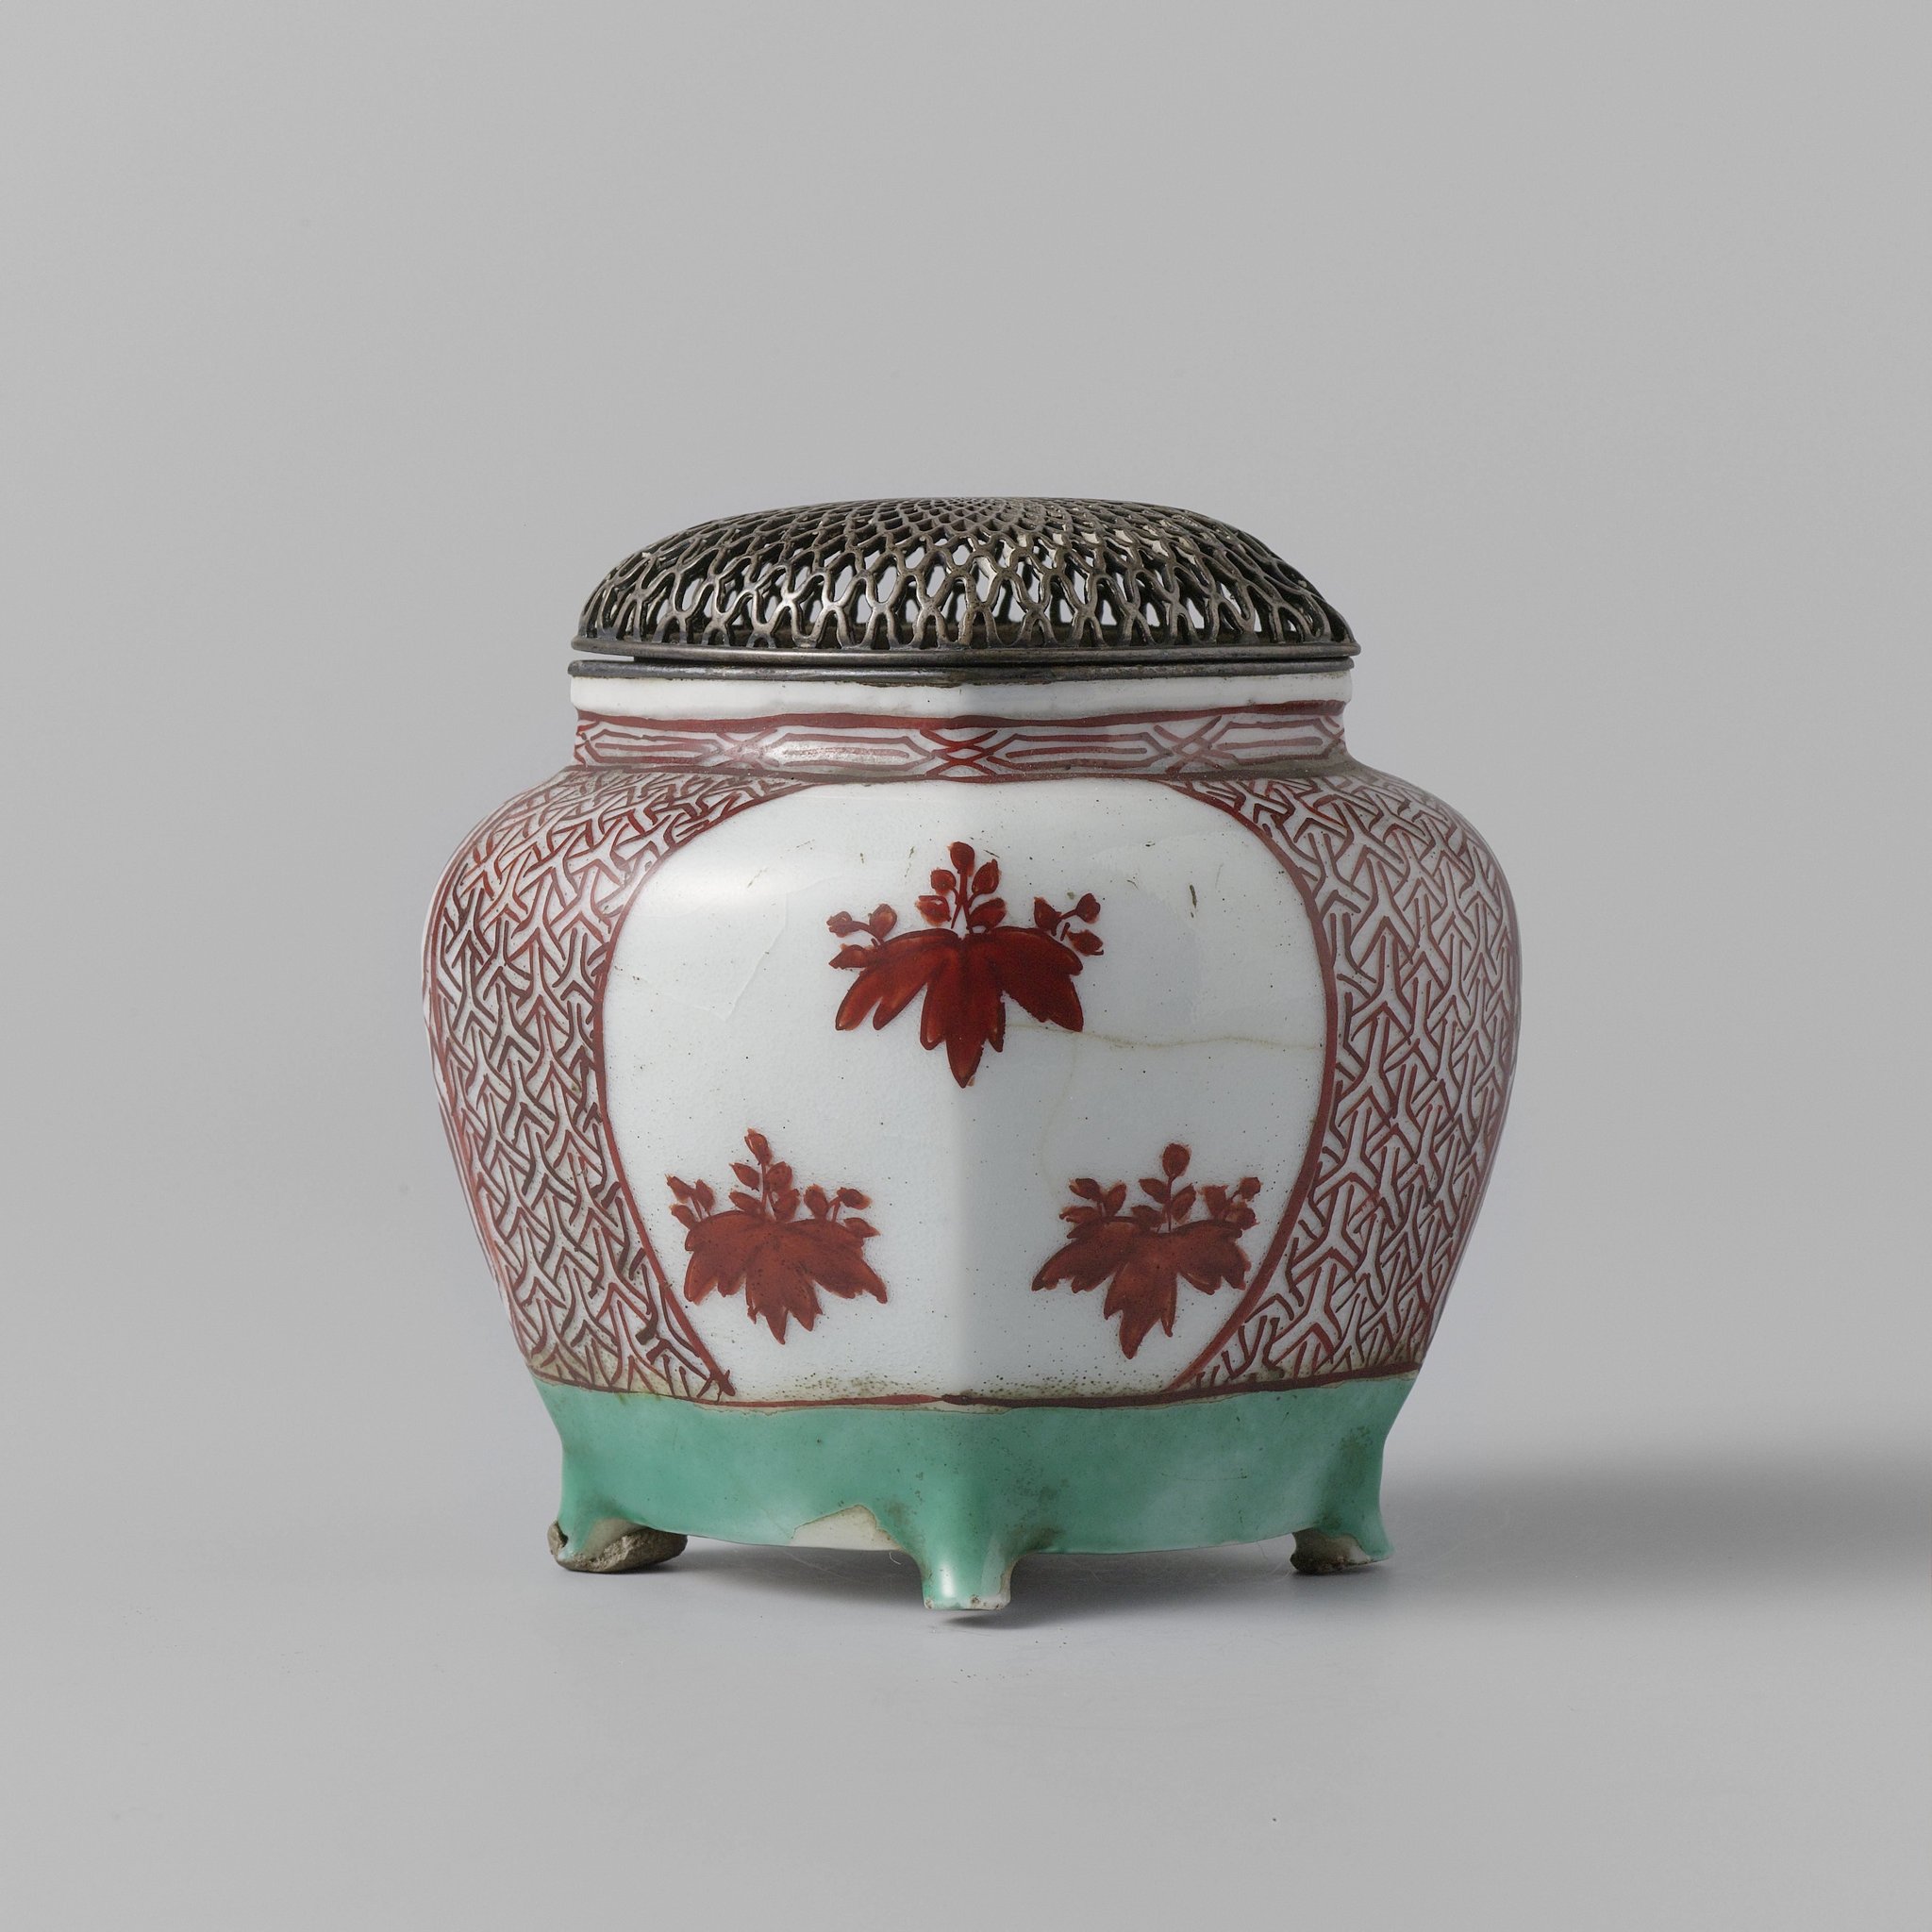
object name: koro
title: Incense burner with leaves and diaper pattern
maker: Anonymous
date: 1800-1899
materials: glaze, paint, porcelain, silver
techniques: firing, forming, turning, vitrification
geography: kutani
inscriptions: label: ‘K. Dingwall Collection/ No. 151’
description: Wierookbrander (koro) van porselein op vier voeten en met een zilveren montuur, beschilderd op het glazuur in rood en turquoise. De wand is bedekt met servetwerk met hierin uitgespaard twee cartouches met in elk drie bladeren. Aan de onderzijde een band in turquoise. De rand is omvat met een zilveren montuur, met daarop een geperforeerde, zilveren deksel. Een voet is gerestaureerd. Oud label op de onderzijde met 'K. Dingwall Collection/ No. 151'. Kutani.